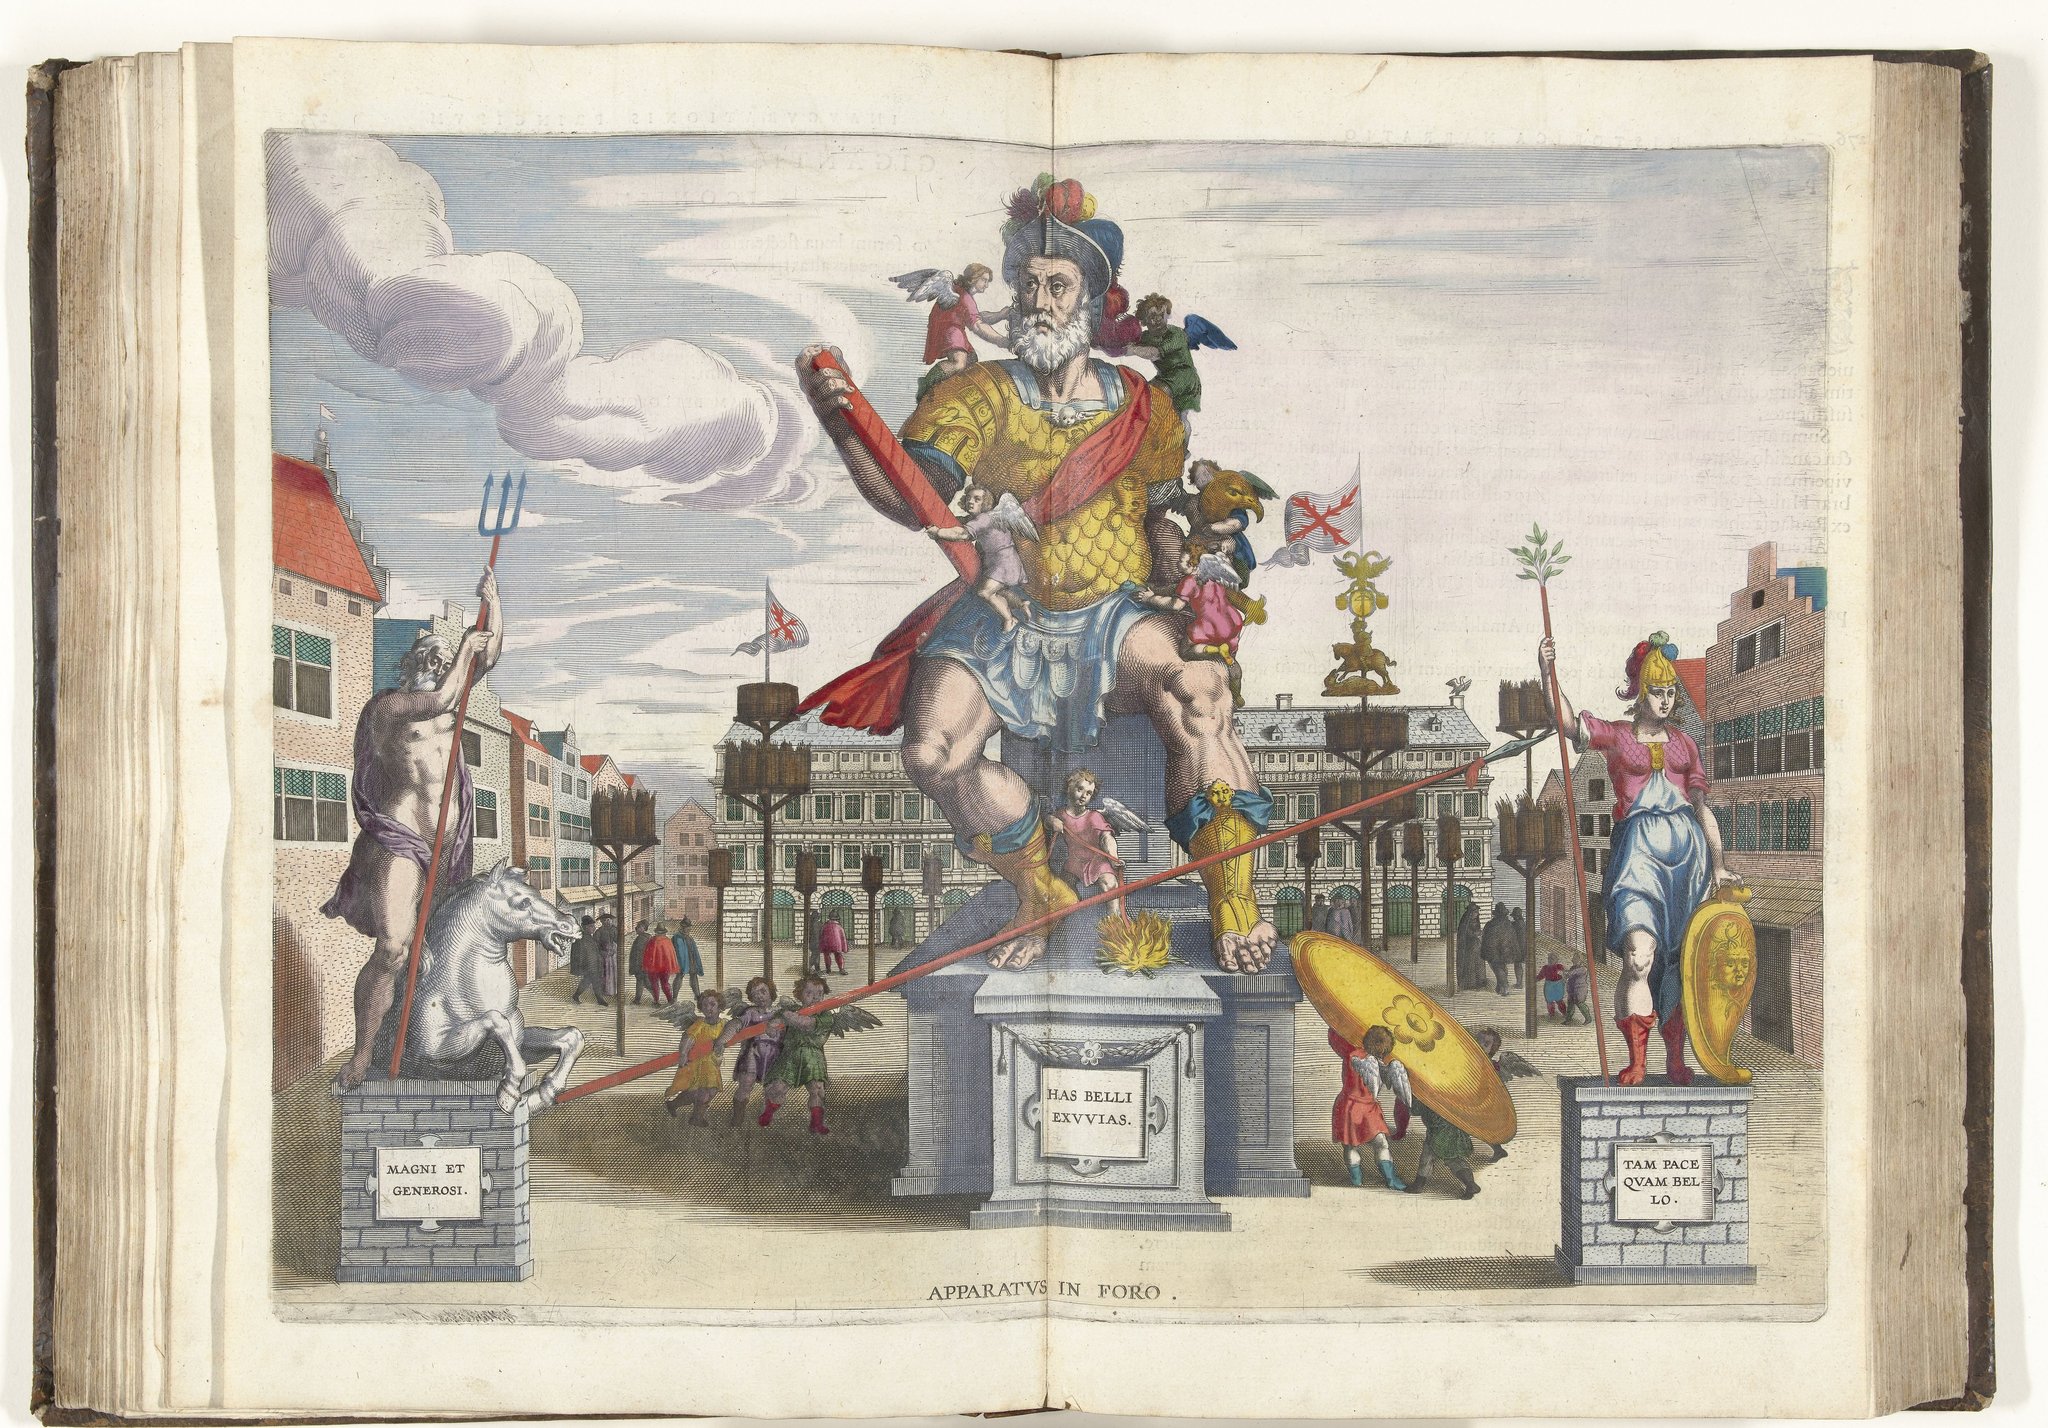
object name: print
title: De reus Antigoon, 1599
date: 1599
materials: paper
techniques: engraving, hand coloring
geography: southern netherlands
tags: infante van spanje isabella clara eugenia, albrecht aartshertog van oostenrijk, triumphal entry and public reception, pageant, 'entrée solennelle', 'joyeuse entrée', other decorative structures (~ triumphal entry, etc.), giants, colossi, antwerp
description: Beeld van de reus Antigoon, december 1599. Standbeelden van de Antwerpse reus, Neptunus en Minerva. Tijdens de intocht te Antwerpen opgesteld op de Grote Markt. Onderdeel van: Historica narratio profectionis et inaugurationis serenissimorum Belgii principum Alberti et Isabellae Austriae archiducum, de beschrijving van de intochten van het paar te Brussel, Antwerpen, Gent en Valenciennes, 1599.